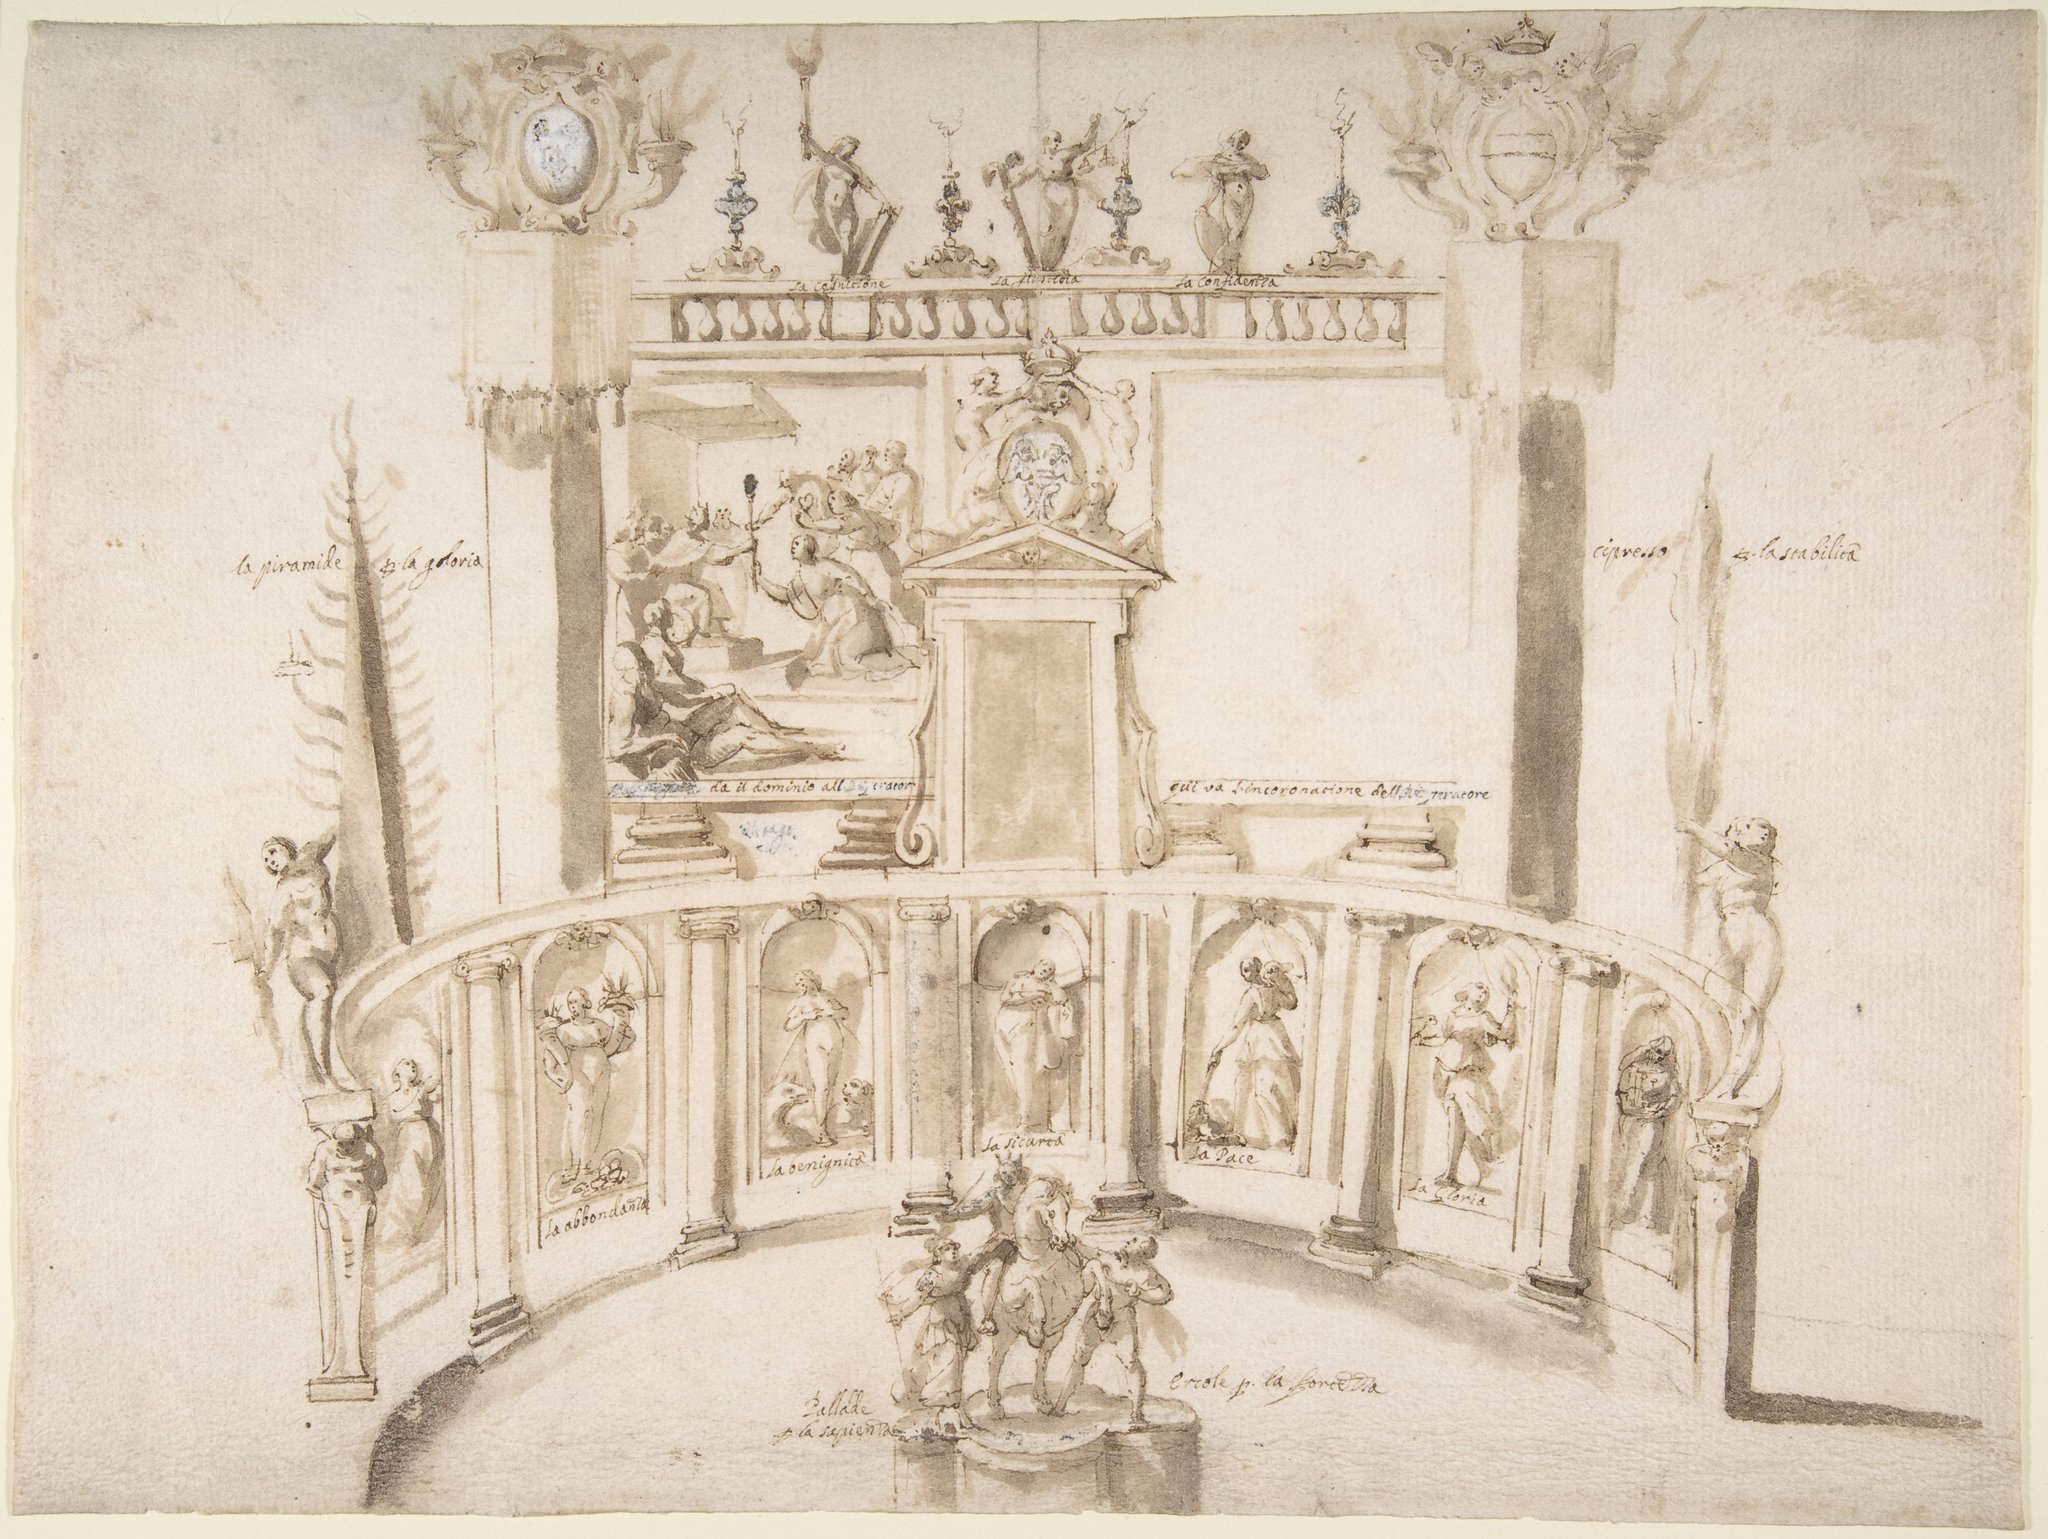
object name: drawing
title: Design for a Garden Fête with a Semi-circular Wall and Statues in Niches.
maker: francesco allegrini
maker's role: artist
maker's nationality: italian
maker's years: 1615-1679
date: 1615-1679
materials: gouache, graphite, ink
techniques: brush, pen, wash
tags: architecture